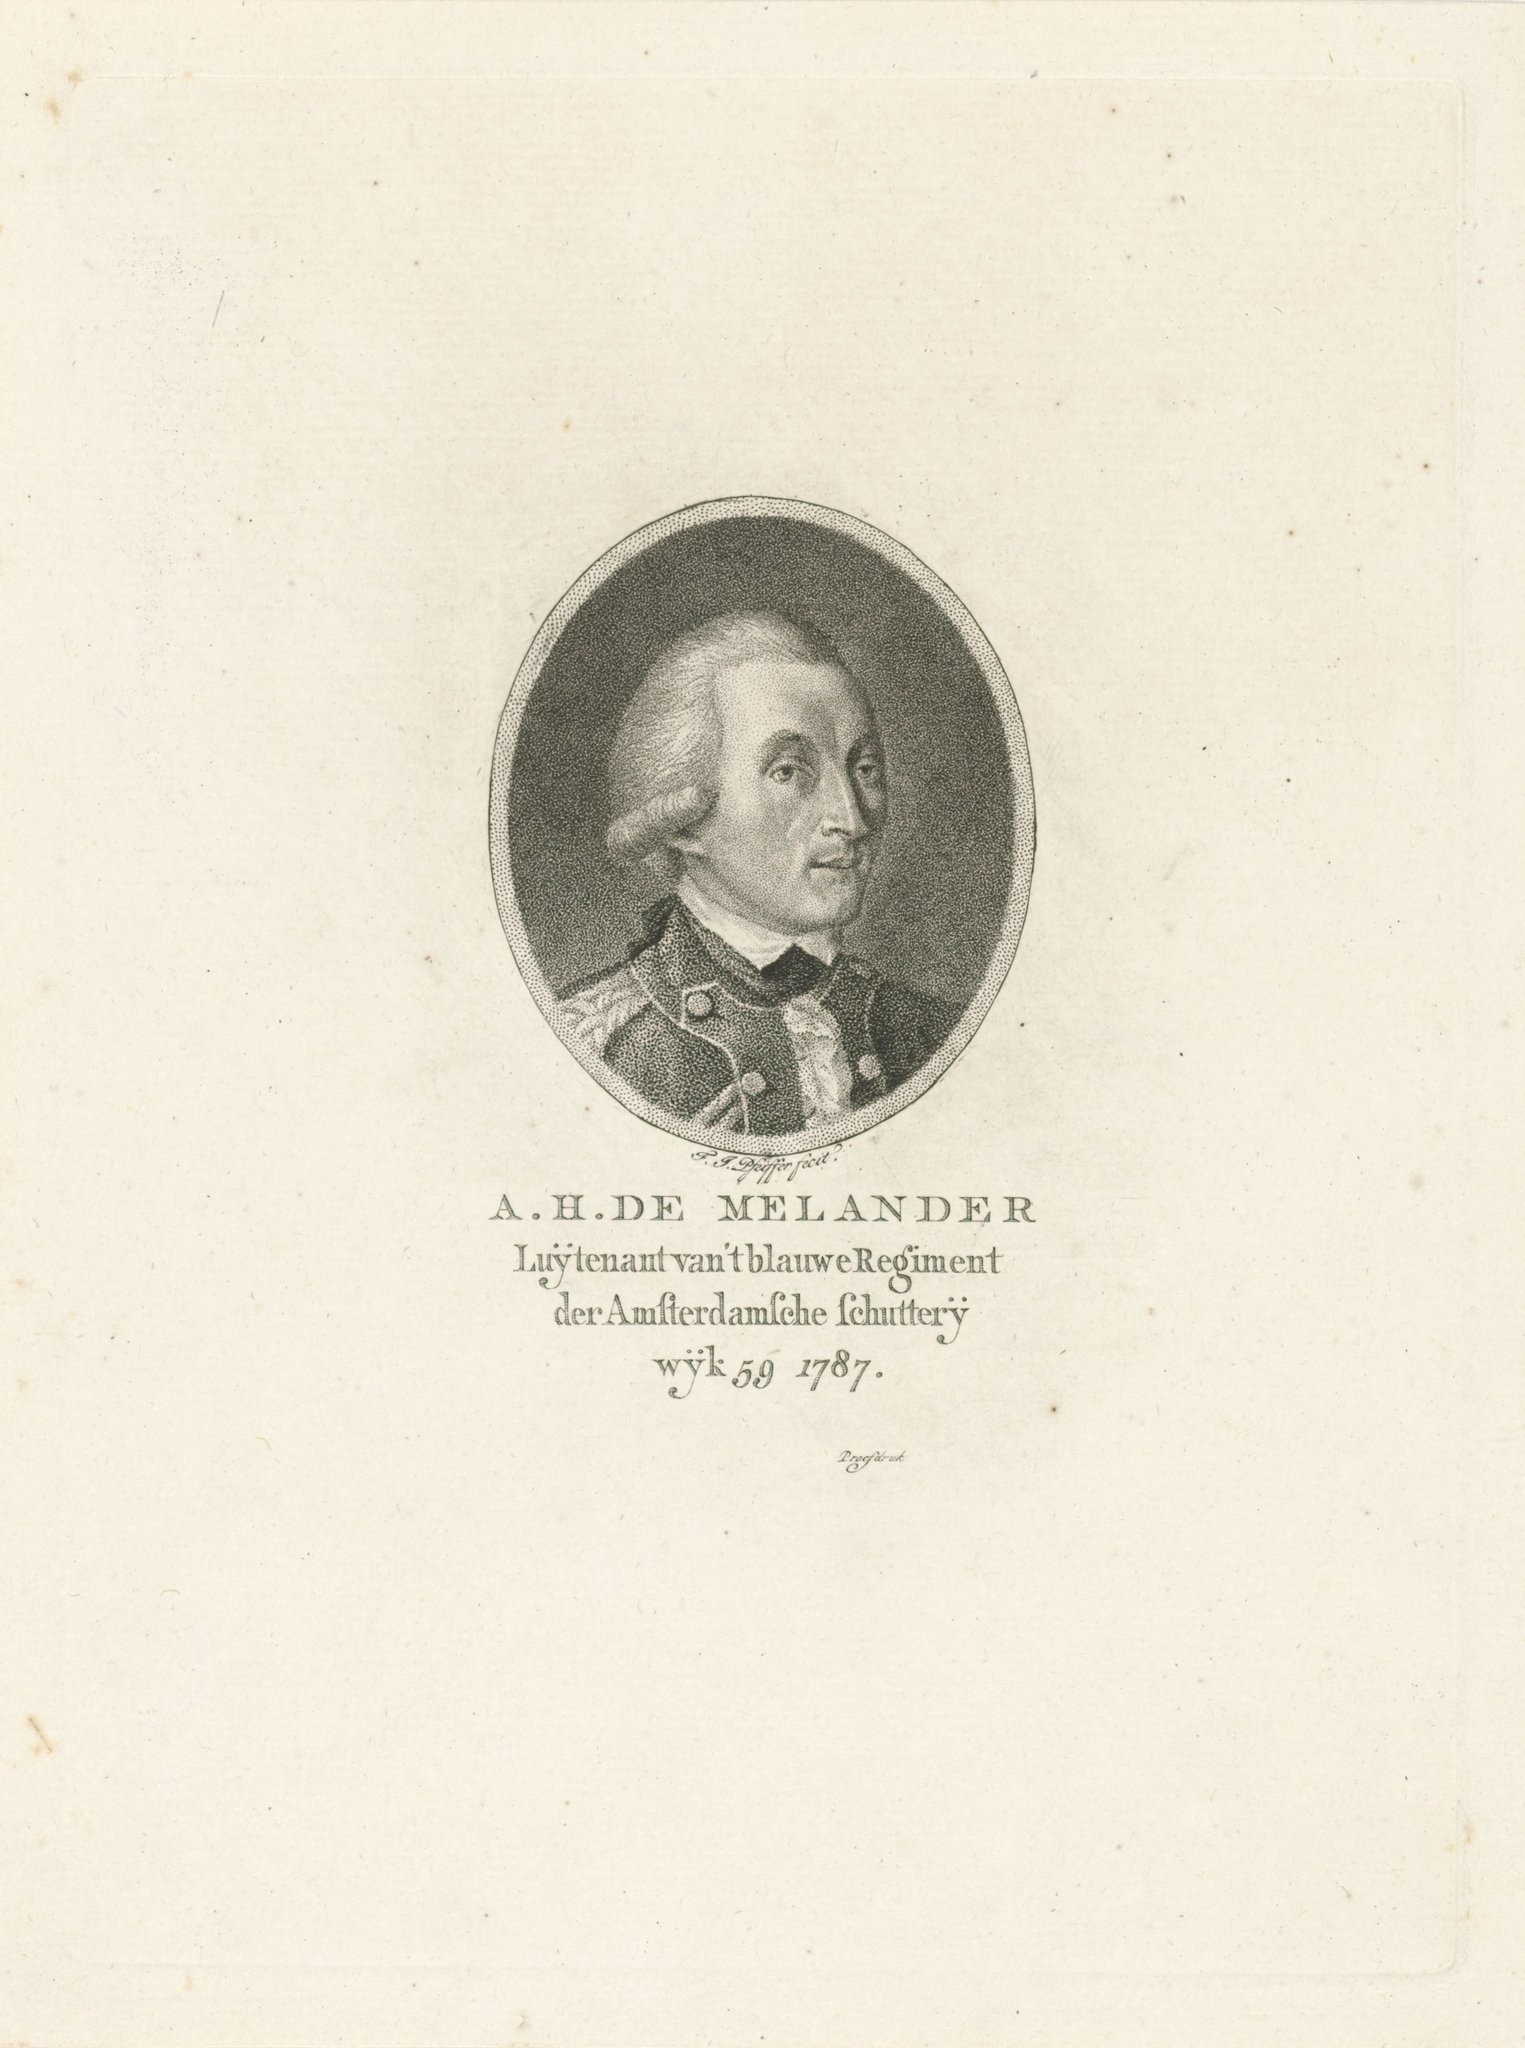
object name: print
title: Portret van August Hendrik de Melander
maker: françois joseph pfeiffer (i)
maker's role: print maker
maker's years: 1741-1807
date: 1787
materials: paper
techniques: aquatint, etching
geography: amsterdam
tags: august hendrik de melander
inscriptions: collector's mark: Lugt 2228